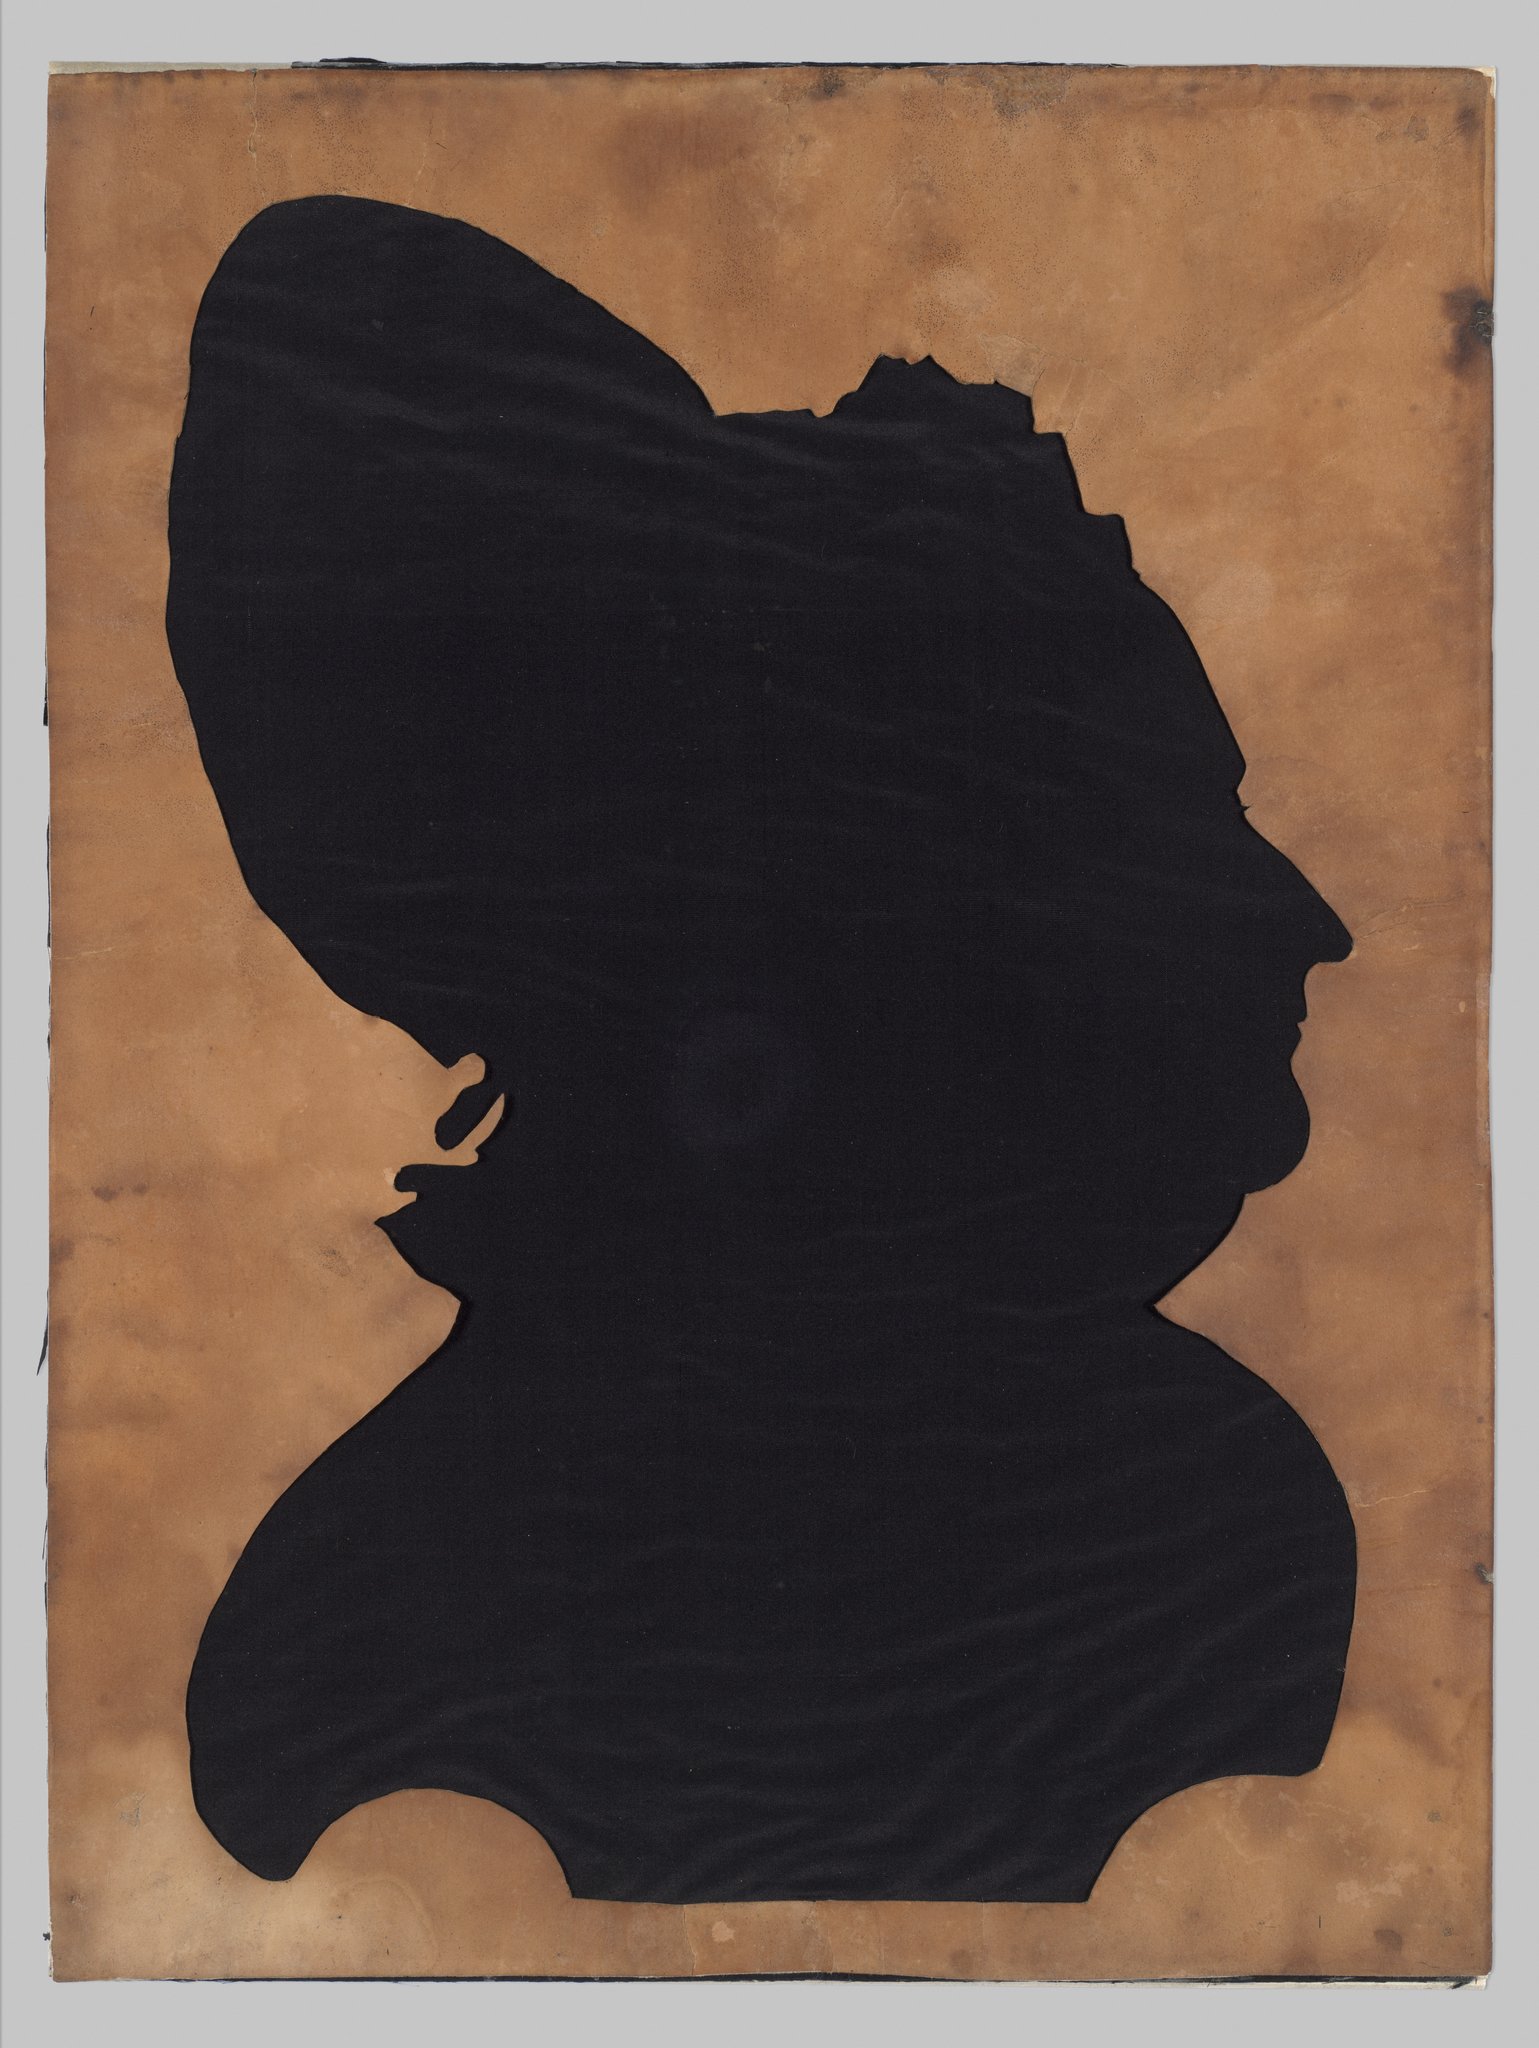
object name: silhouette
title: Portrait of Martha Washington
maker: eleanor parke custis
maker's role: artist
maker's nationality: american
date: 1798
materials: linen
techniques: cutting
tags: portraits,profiles,women